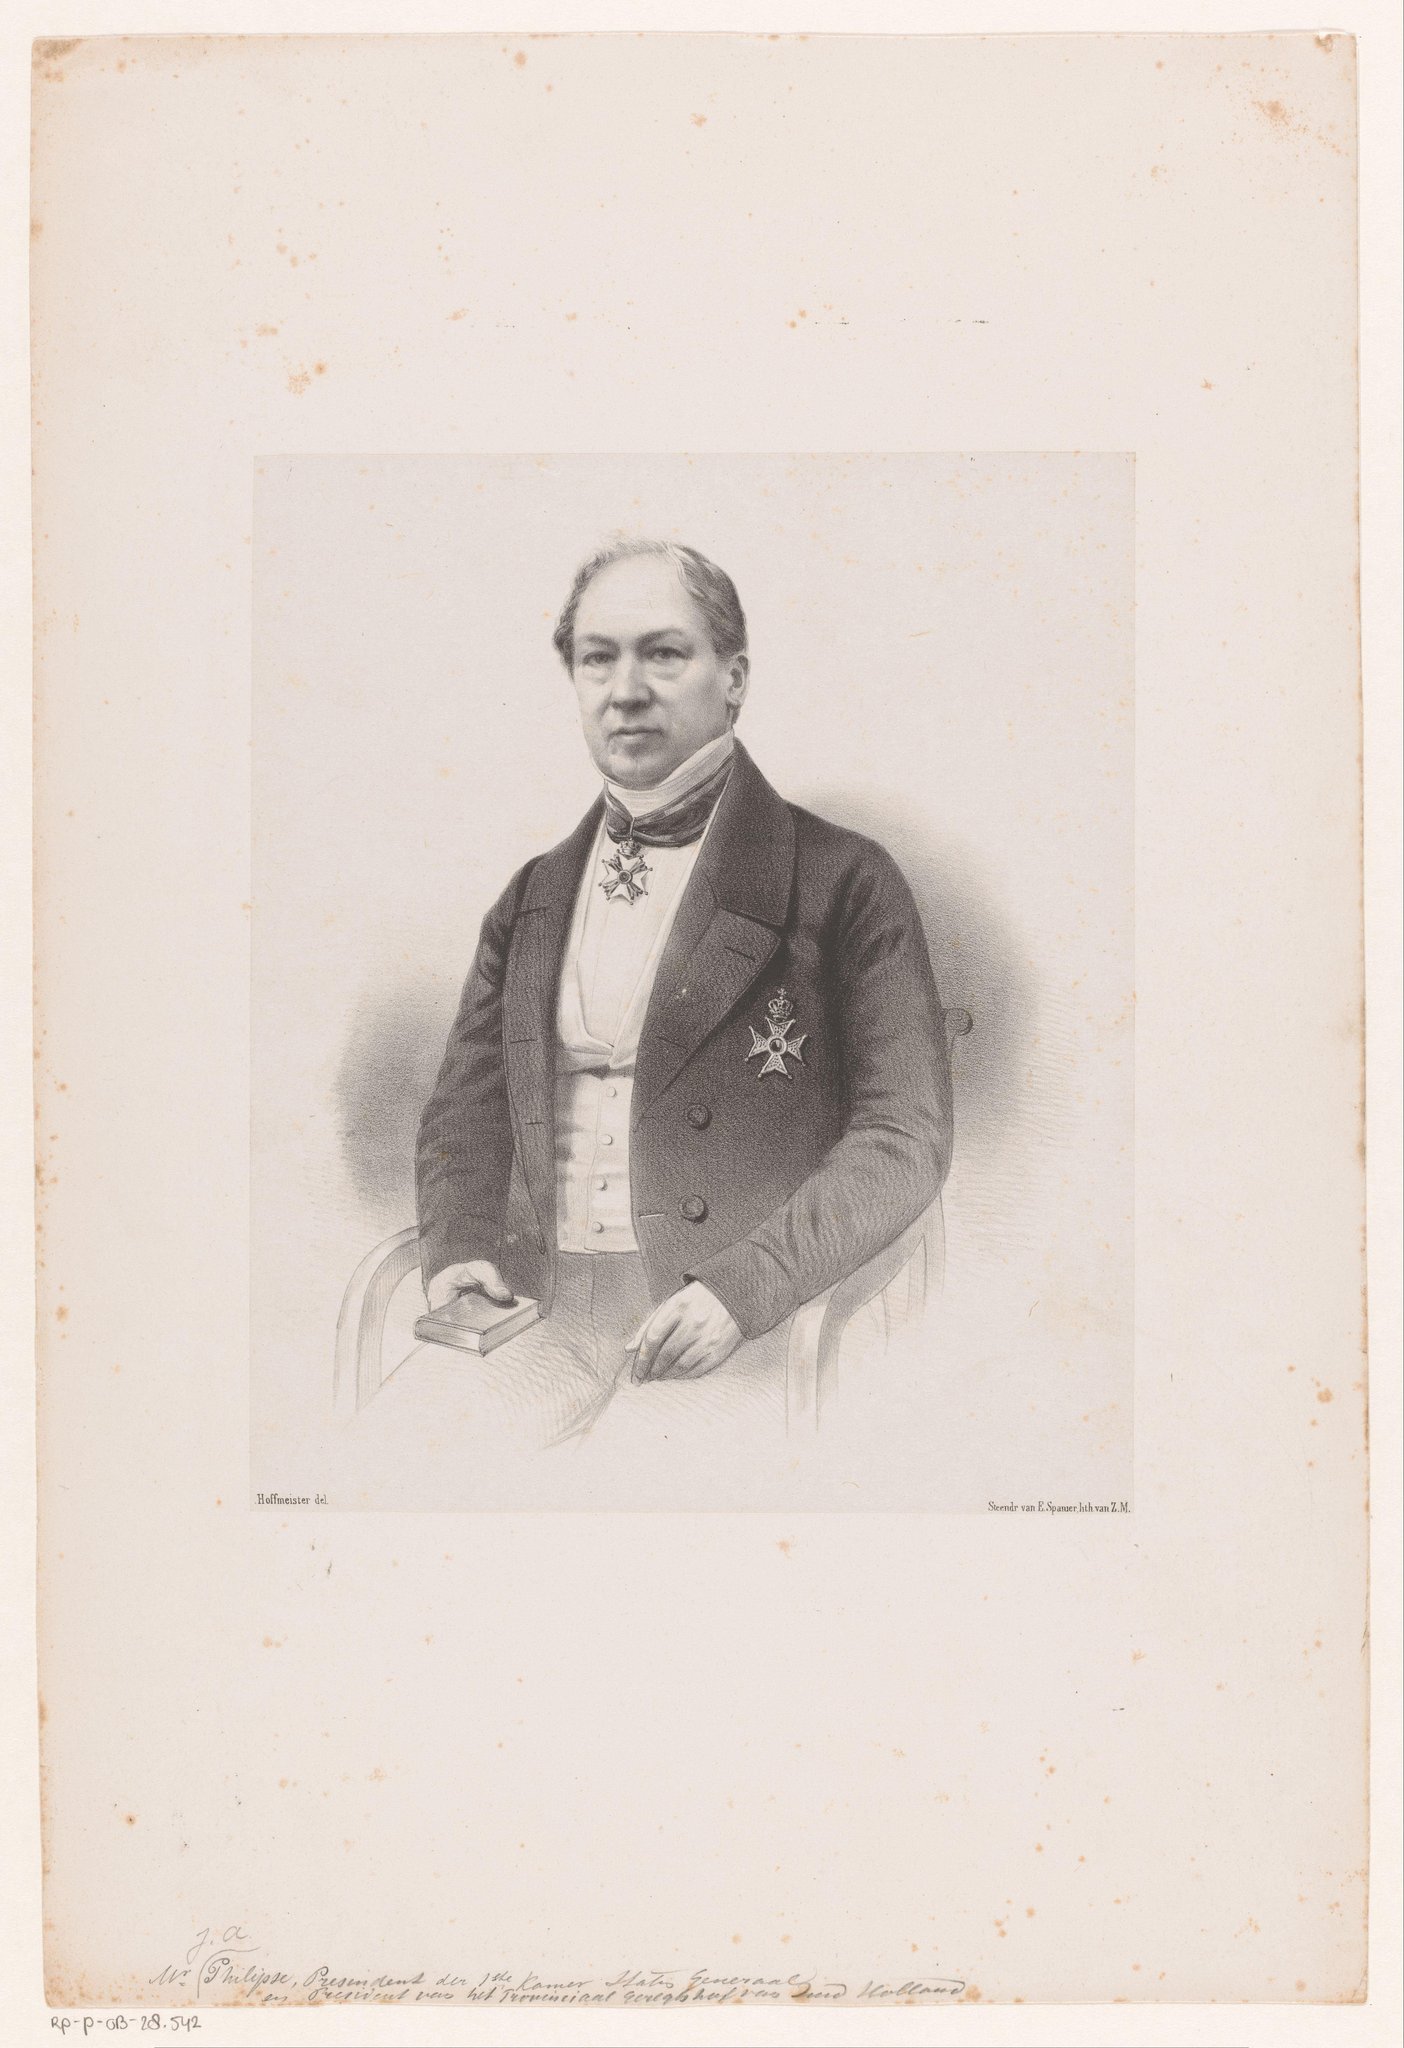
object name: print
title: Portret van Johan Antoni Philipse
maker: johan hendrik hoffmeister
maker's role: print maker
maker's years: 1823-1904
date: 1851-1883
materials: paper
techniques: lithograph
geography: netherlands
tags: middelburg, politician, knighthood order, historical persons (+ (full) bust portrait)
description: De geportretteerde draagt een ridderorde op de borst en om zijn hals. In zijn rechterhand heeft hij een boek.